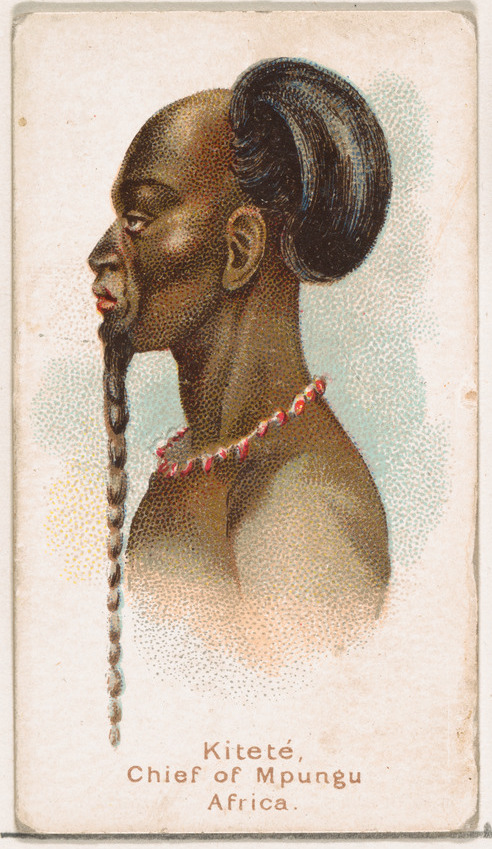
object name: print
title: Kitete, Chief of Mpungu, Africa, from the Savage and Semi-Barbarous Chiefs and Rulers series (N189) issued by Wm. S. Kimball & Co.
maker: william s. kimball & company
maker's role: publisher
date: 1888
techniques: color lithograph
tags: men,profiles